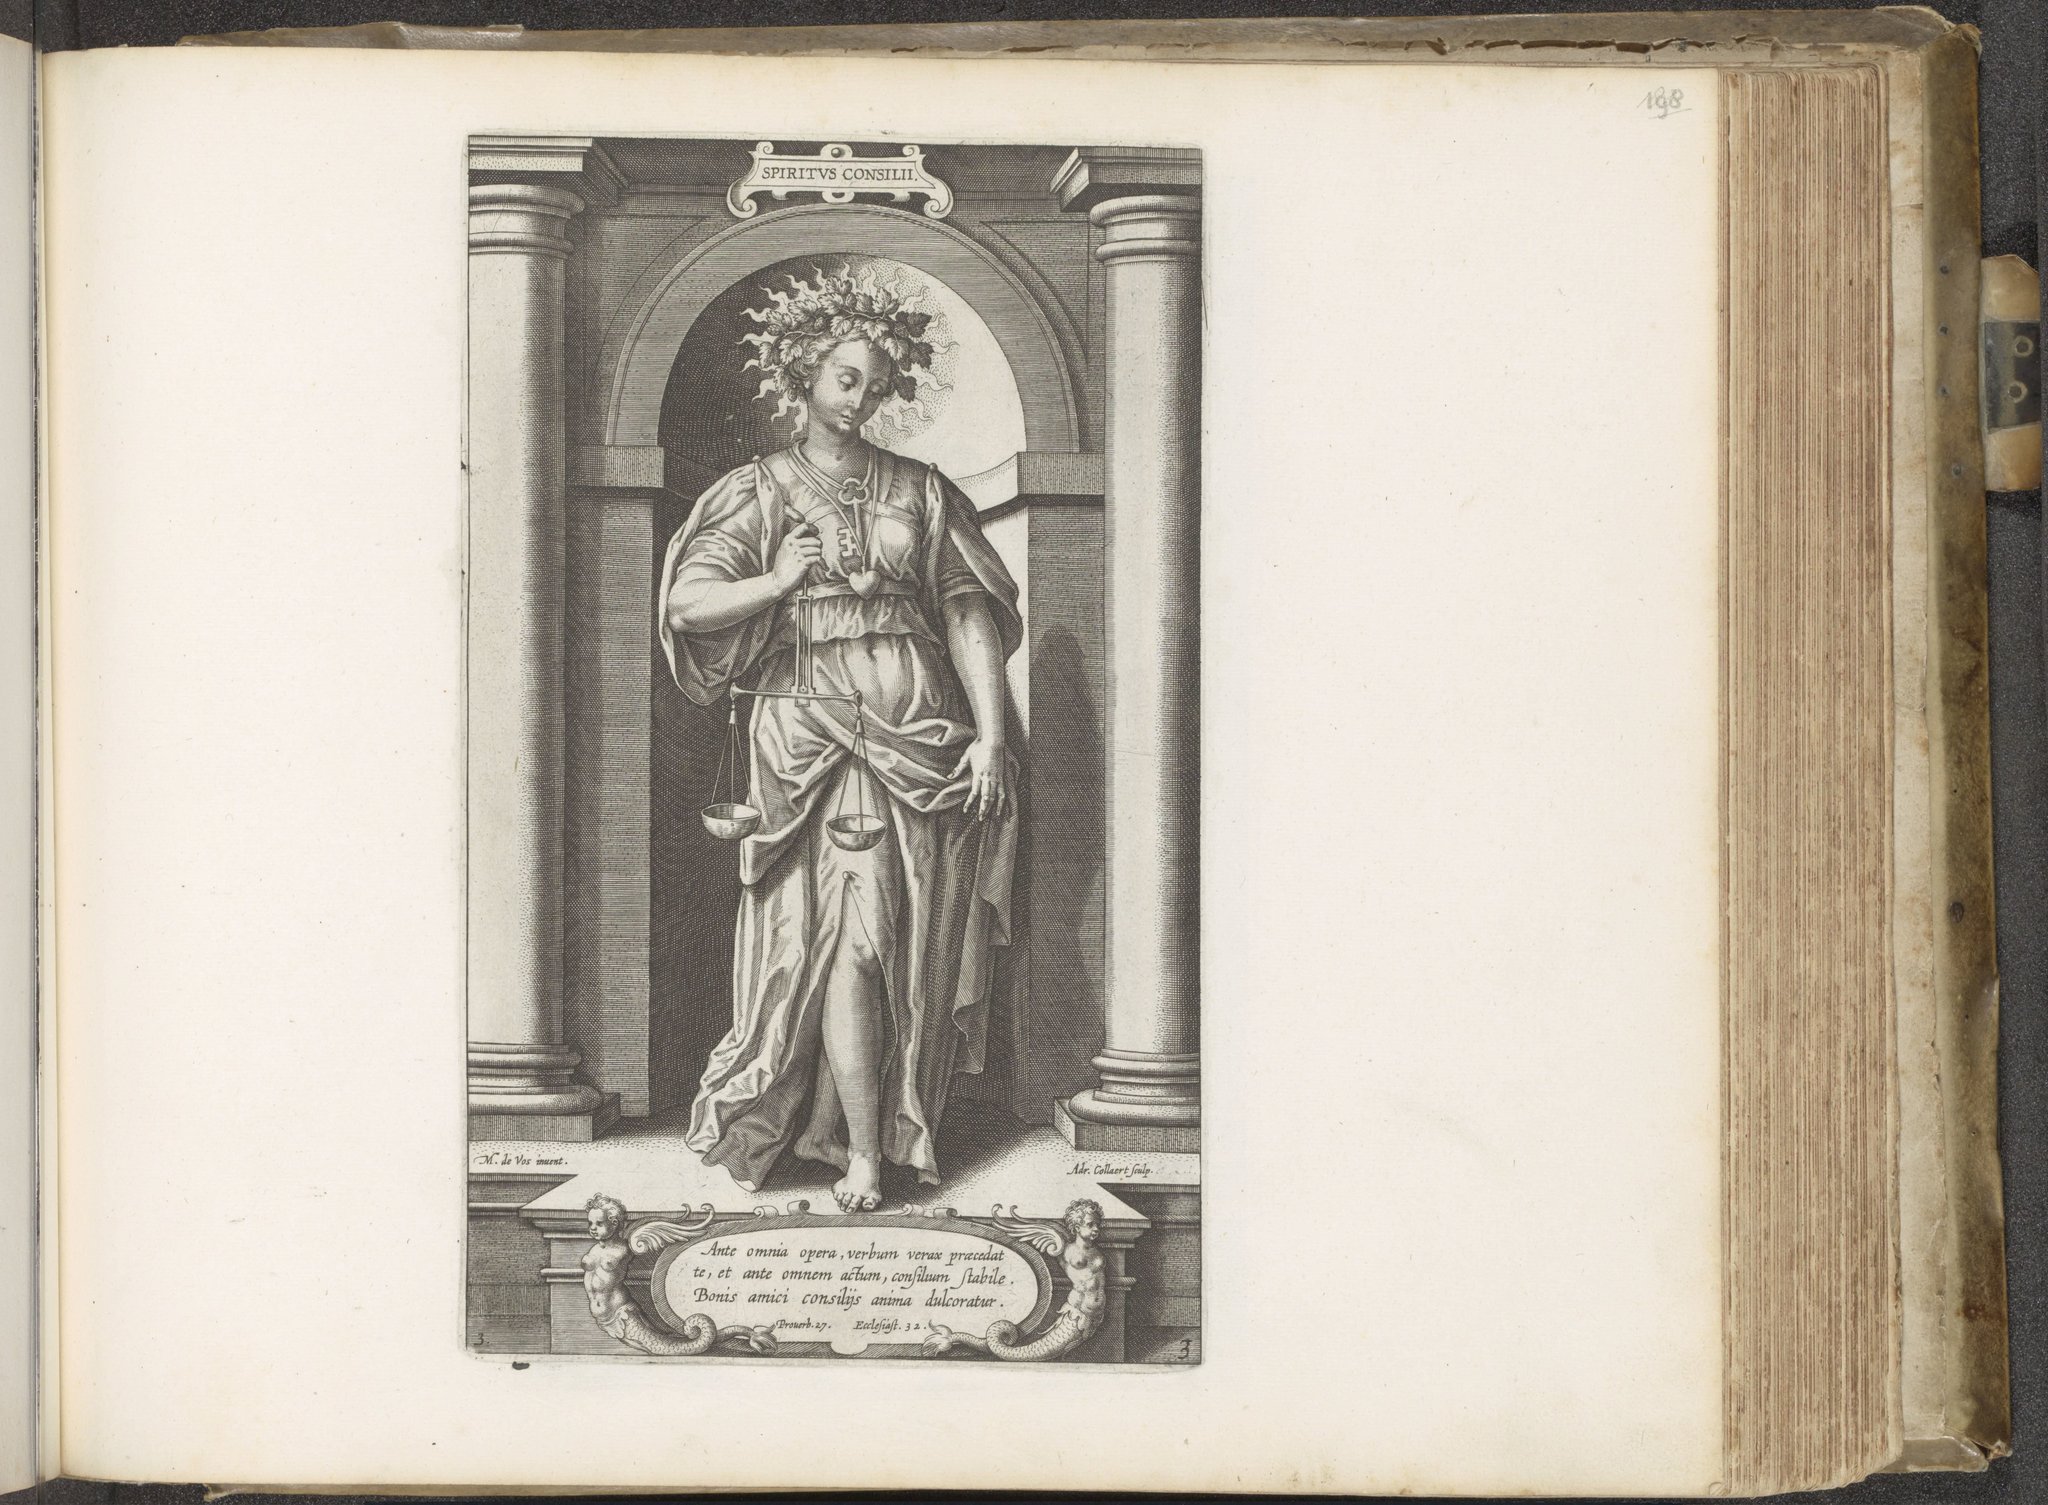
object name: print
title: Septem Dona Spiritus Sancti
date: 1653-1654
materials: paper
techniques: engraving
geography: amsterdam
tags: 'consilium', counsel ~ one of the seven gifts of the holy ghost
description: In een nis de vrouwelijke personificatie van de gave van raadgeving, een van de zeven gaven van de Heilige Geest. Ze draagt een kroon van bladeren en heeft een sleutel en een hart aan twee halskettingen om haar nek. In haar rechterhand heeft ze een weegschaal. Onderaan de Bijbeltekst uit Spreuken 27:9 en Wijsheid van Jezus Sirach 32 in het Latijn. De prent maakt deel uit van een album.